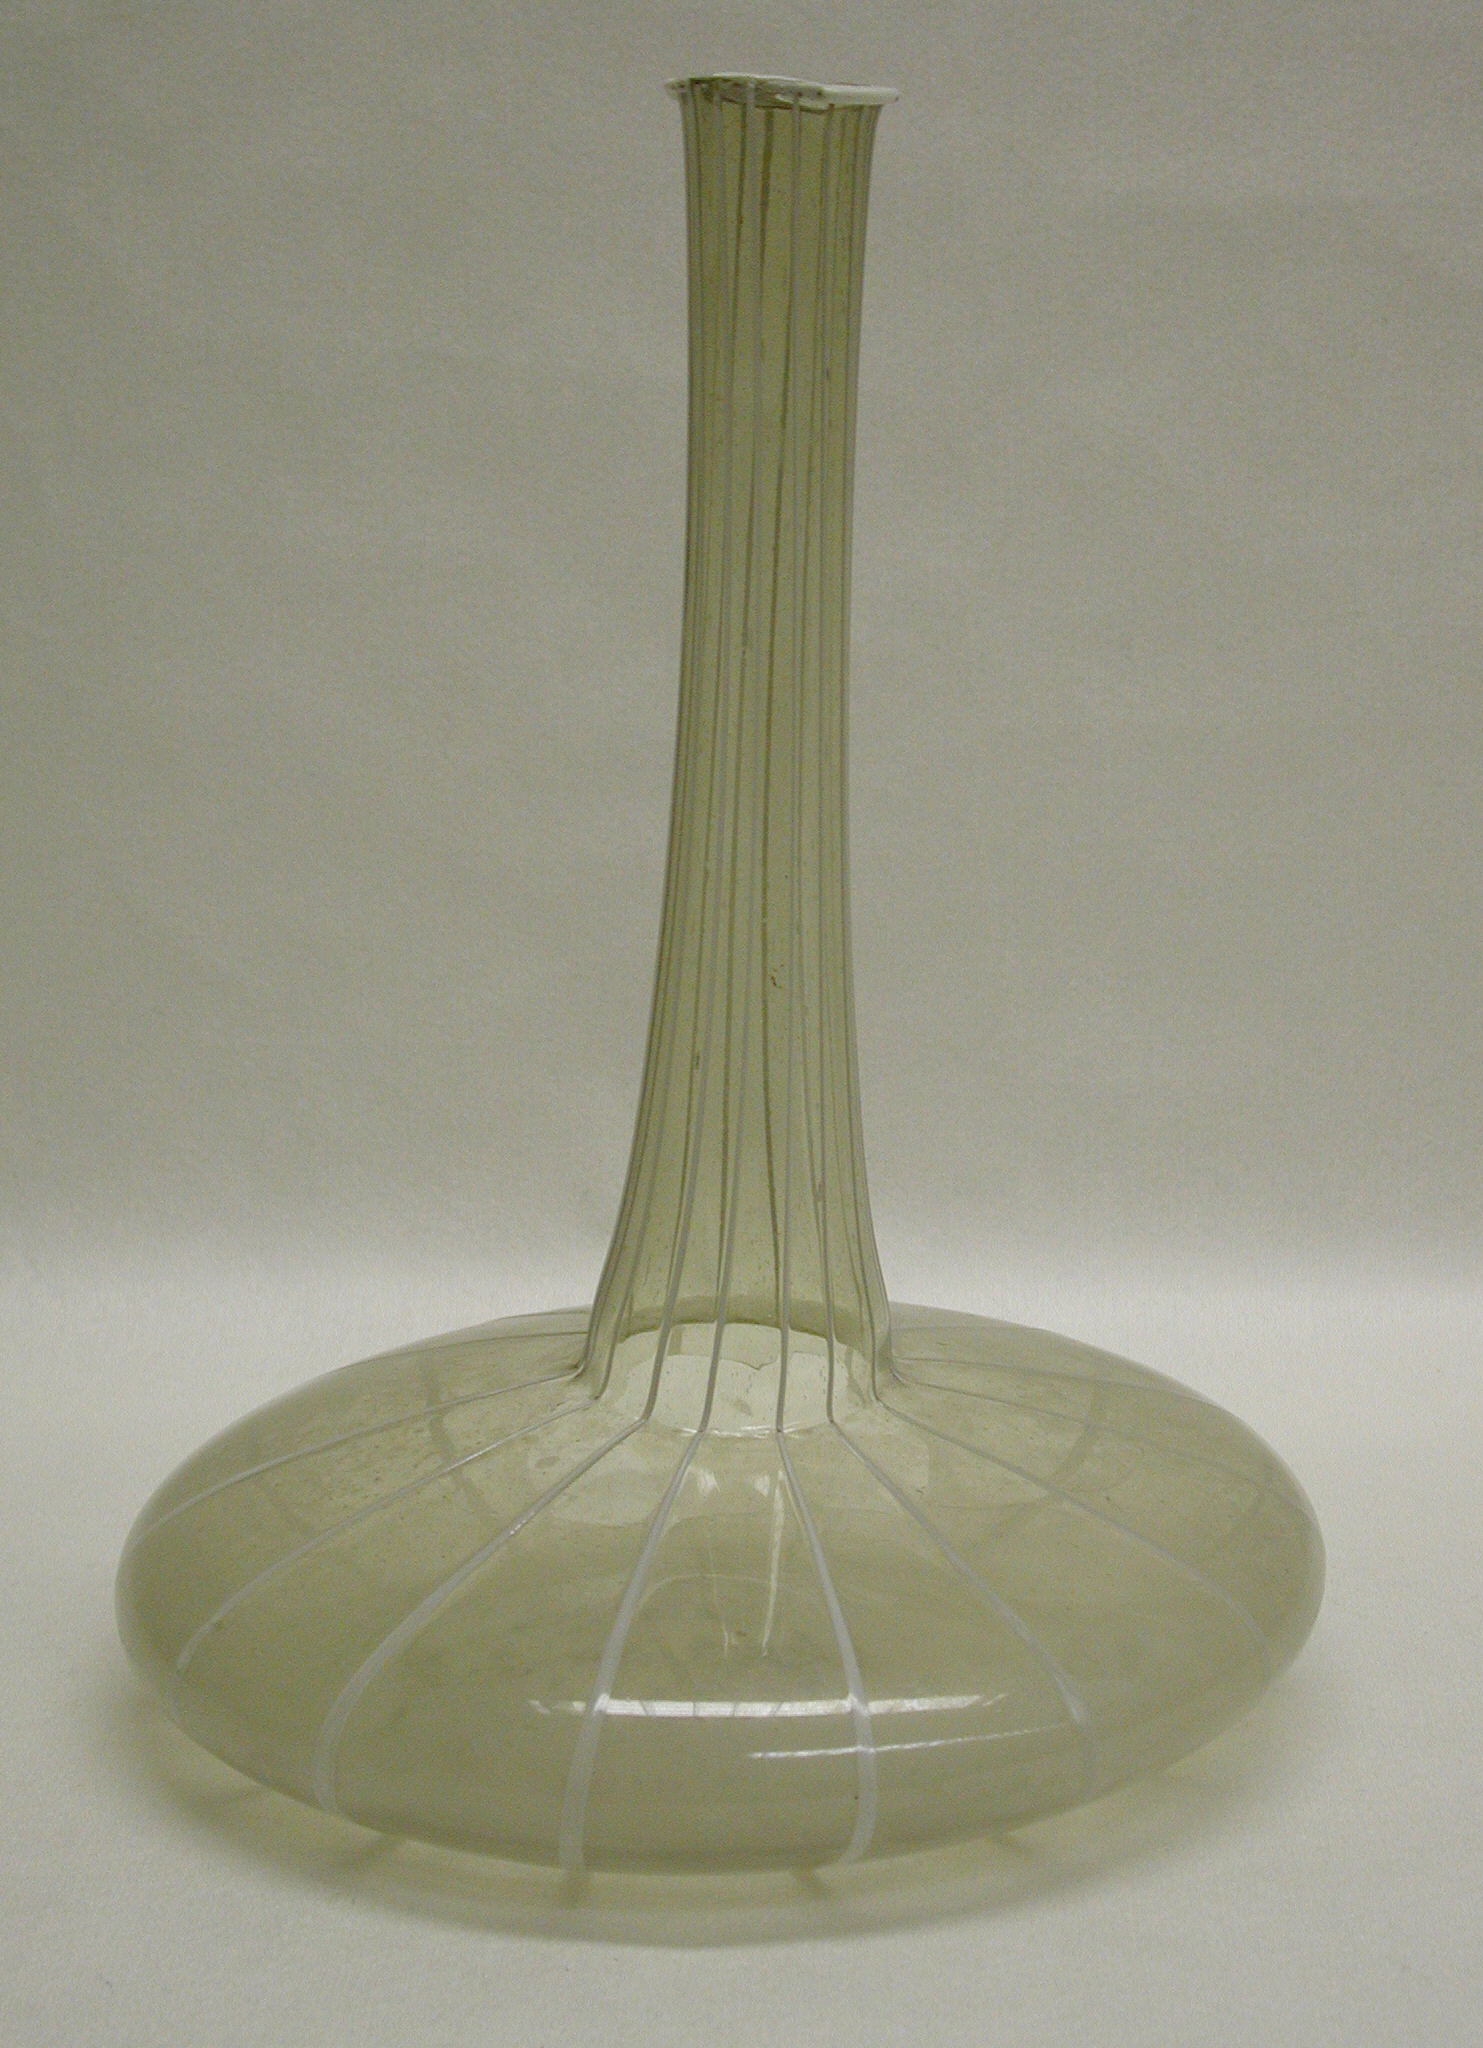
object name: bottle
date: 1501-1600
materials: glass